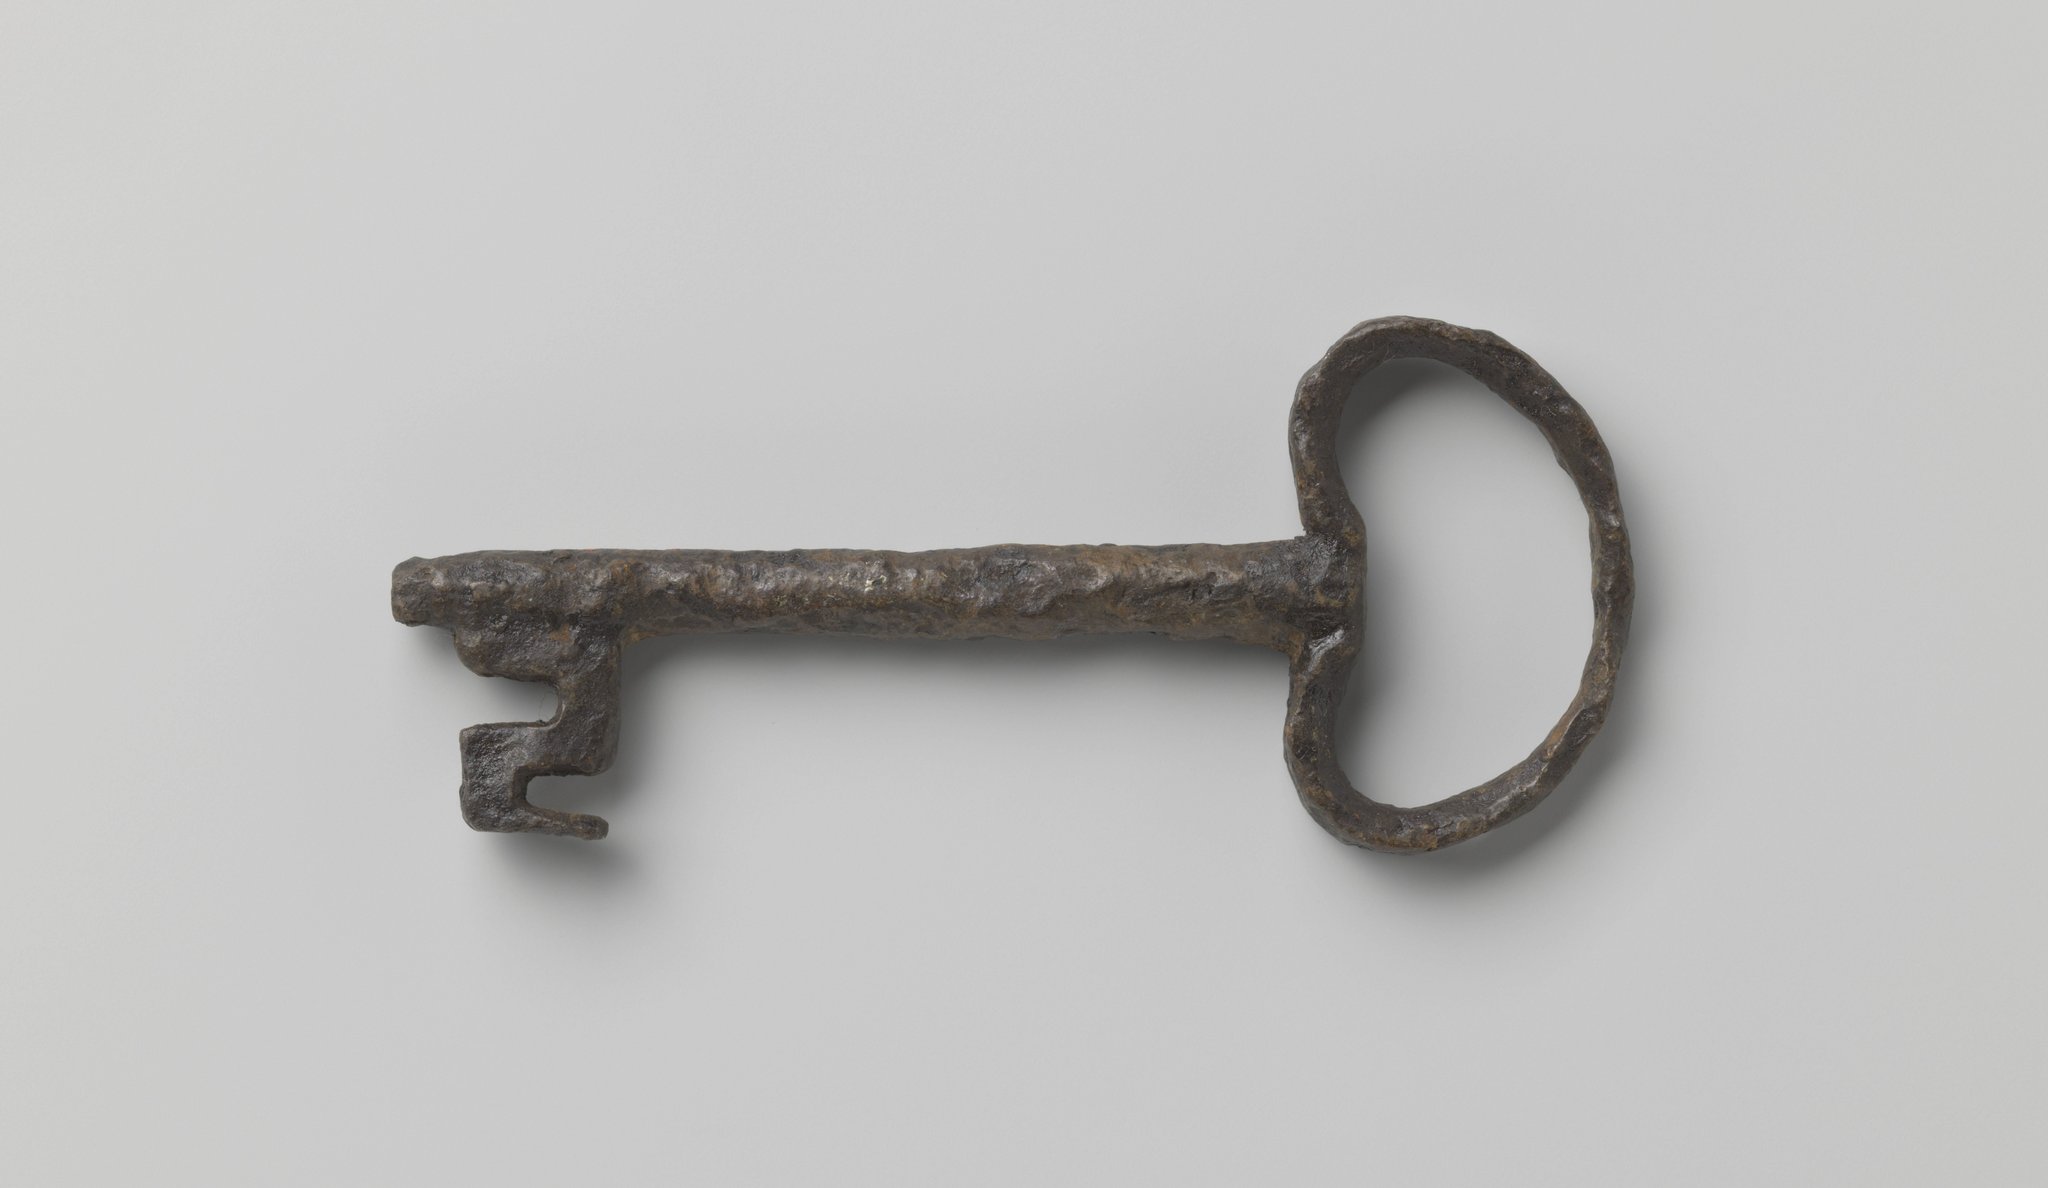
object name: key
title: Sleutel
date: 1500-1600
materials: iron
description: Sleutel met boonvormig oog en kleine haakvormige baard. De schacht loopt even voorbij de baard door.